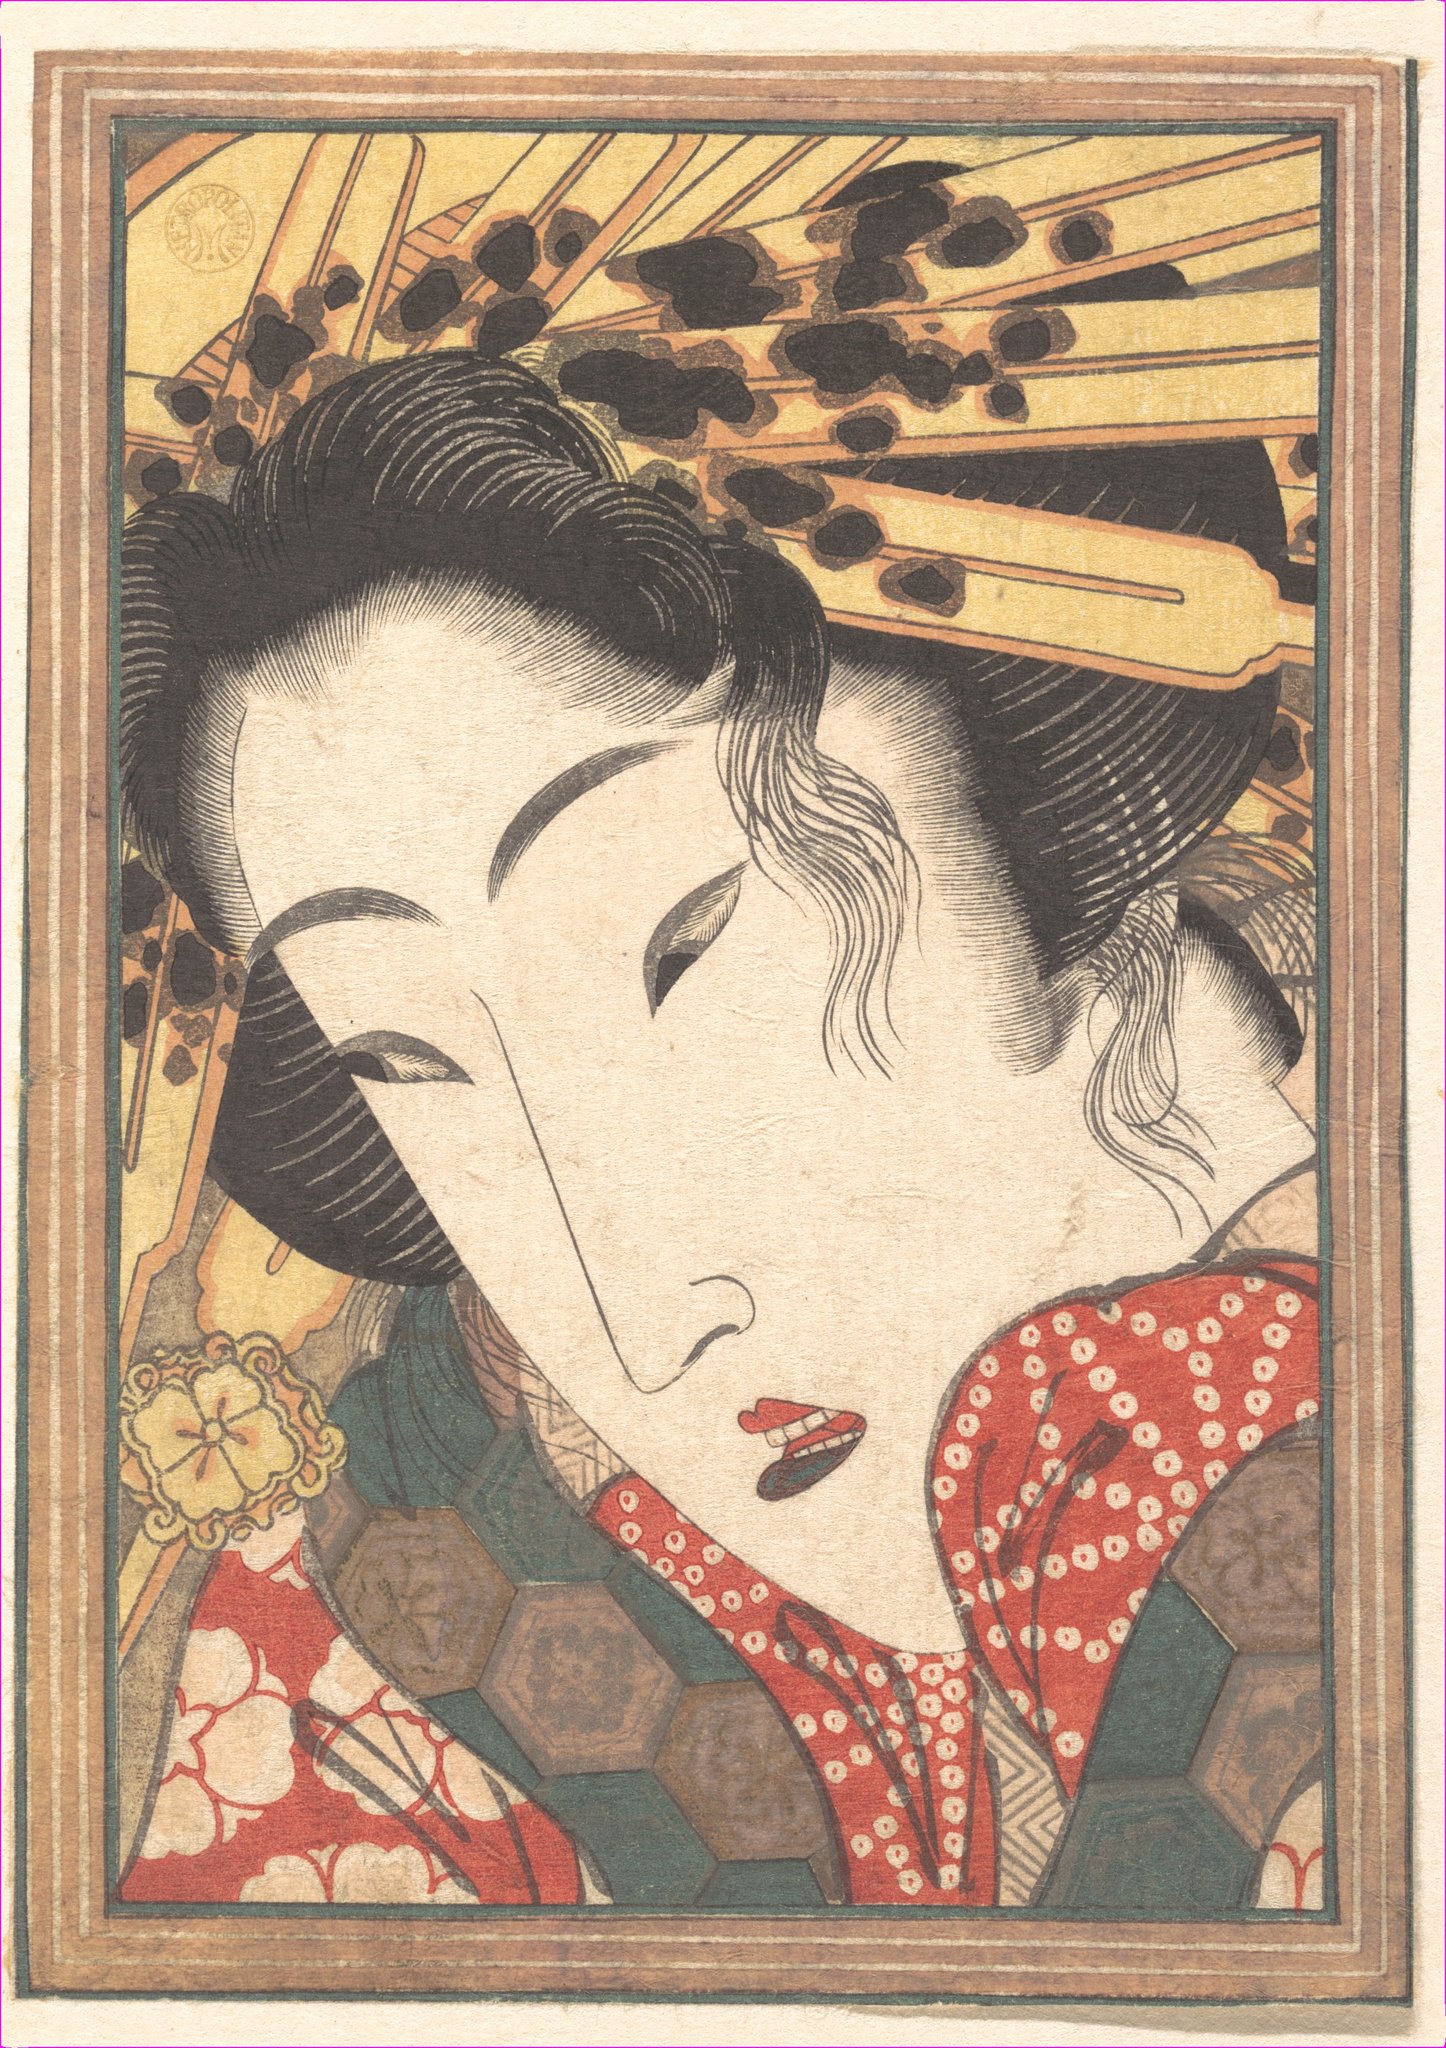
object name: print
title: Rejected Geisha from Passions Cooled by Springtime Snow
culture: japanese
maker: keisai eisen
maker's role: artist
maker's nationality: japanese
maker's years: 1790-1848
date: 1824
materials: ink, paper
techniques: woodblock print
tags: portraits,women